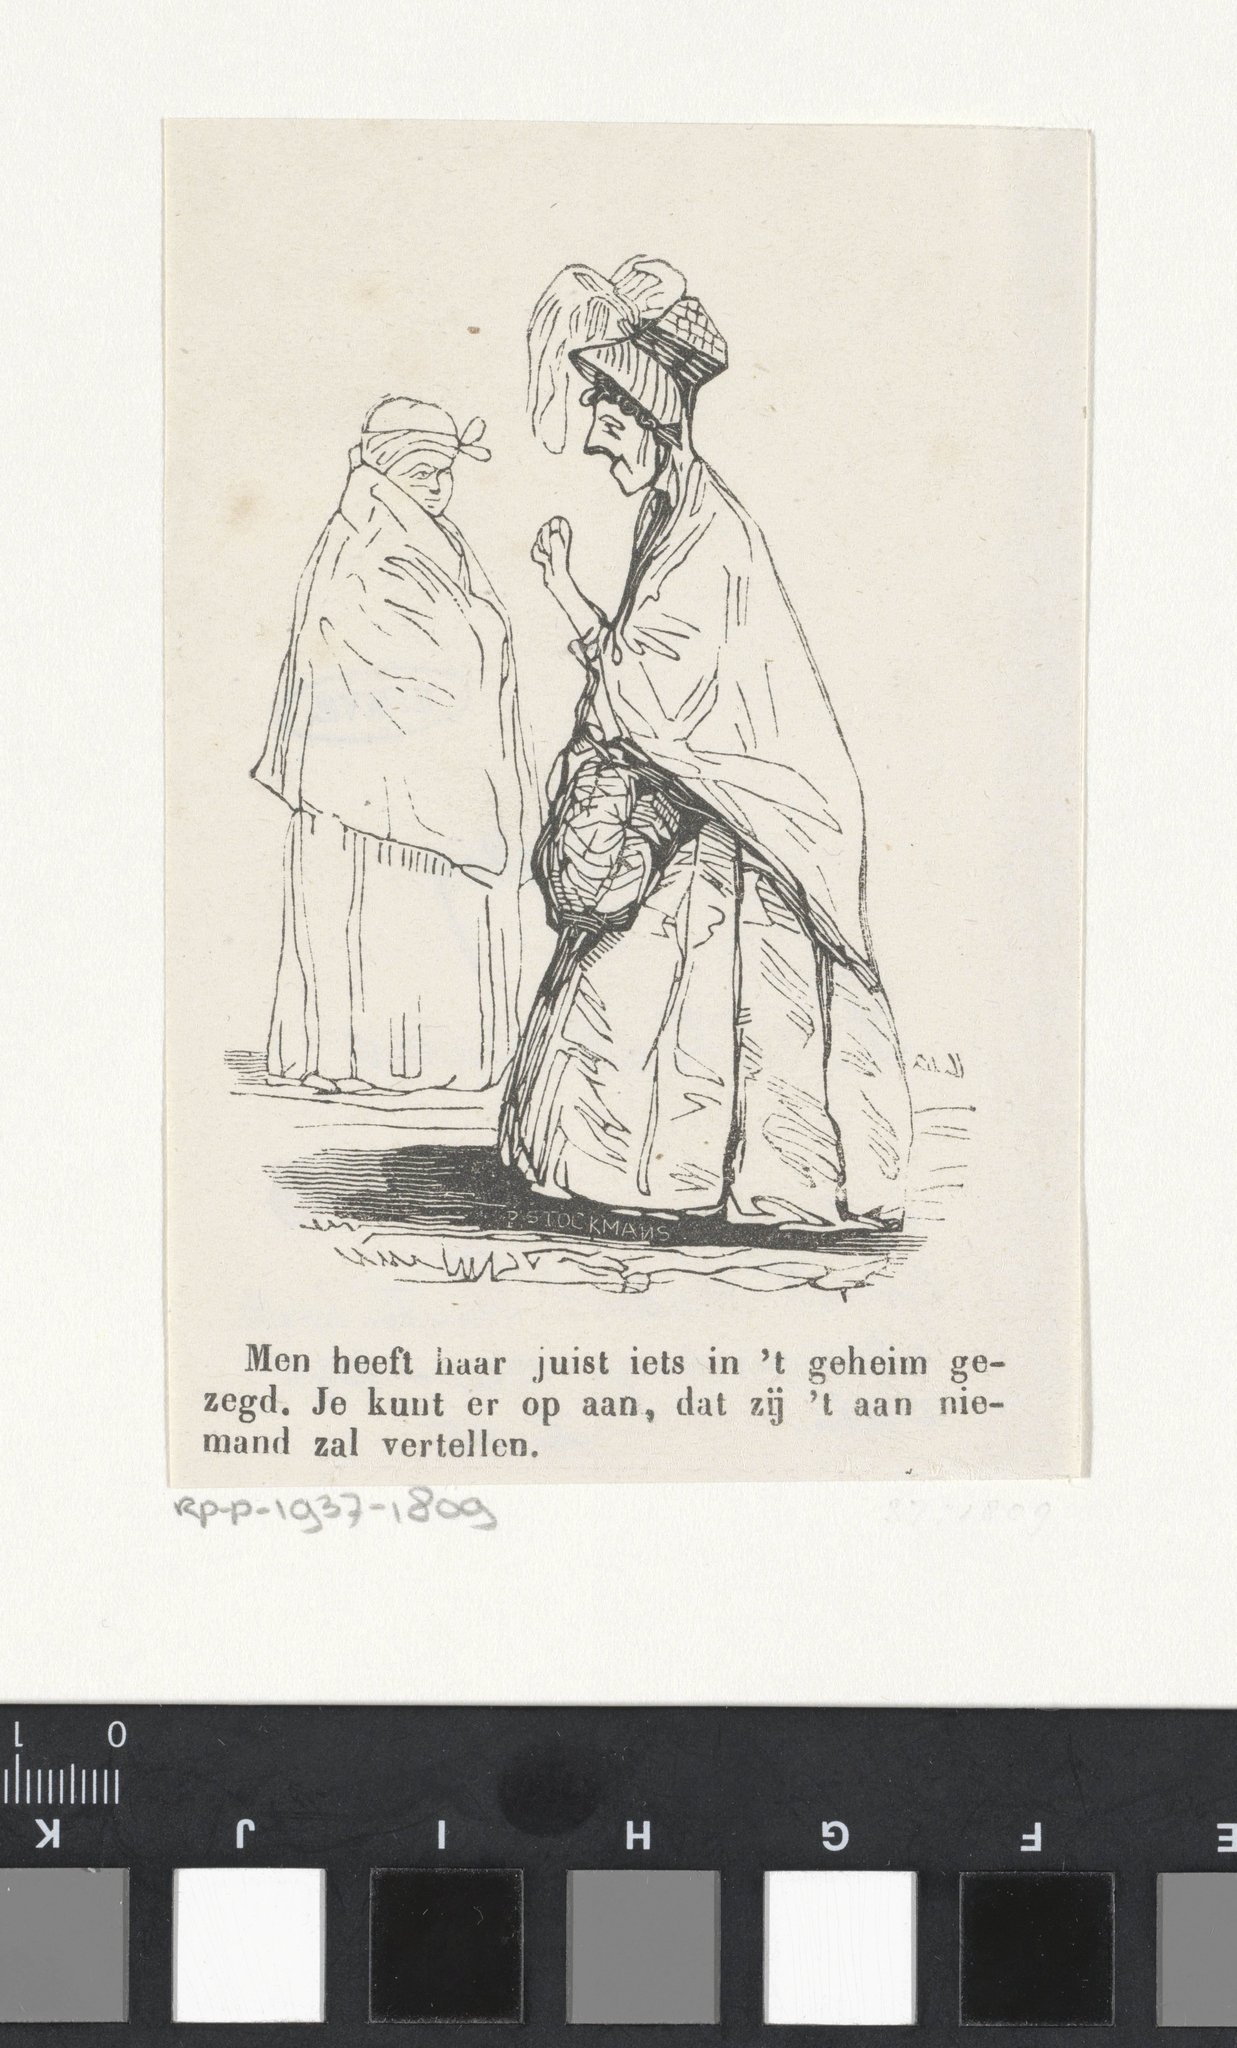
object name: print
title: Twee vrouwen met schoudermantels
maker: p. stockmans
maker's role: print maker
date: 1800-1899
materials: paper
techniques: letterpress printing, engraving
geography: netherlands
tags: cape (+ women's clothes)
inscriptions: collector's mark: Lugt 2760, collector's mark: Lugt 2228